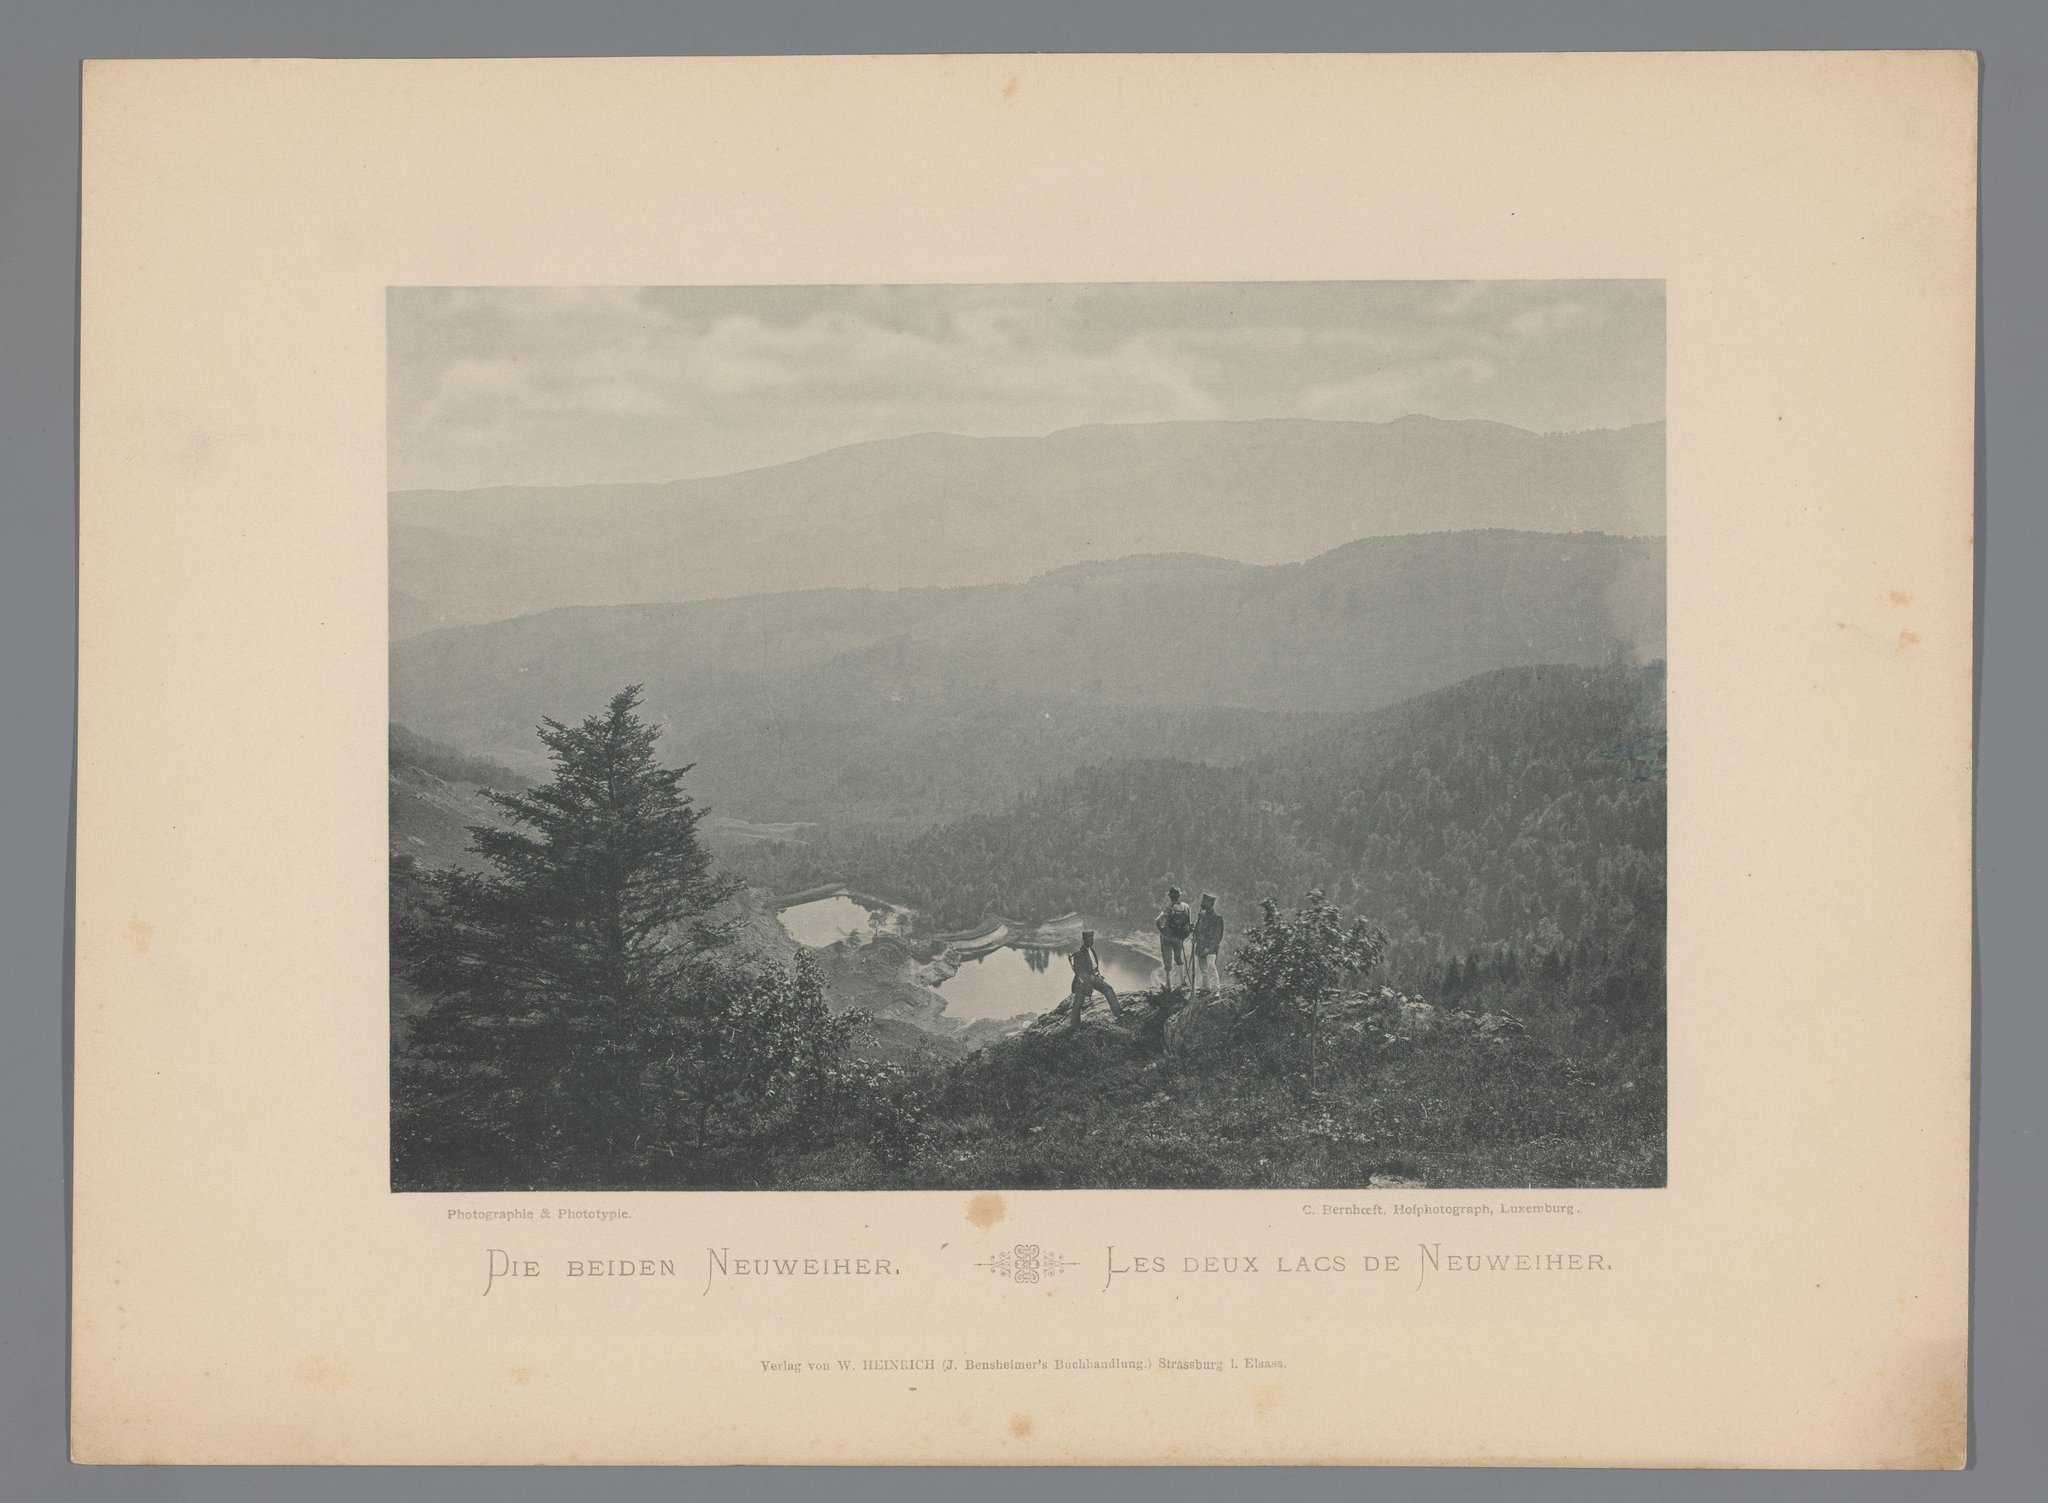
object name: page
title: Die beiden Neuweiher, Les deux lacs de Neuweiher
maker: charles bernhoeft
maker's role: publisher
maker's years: 1859-1933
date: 1889-1894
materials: paper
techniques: photograph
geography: grand est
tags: walking, hiking (recreation), lake (+ landscape with figures, staffage)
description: Deze prent maakt deel uit van een omslag met 100 prenten.